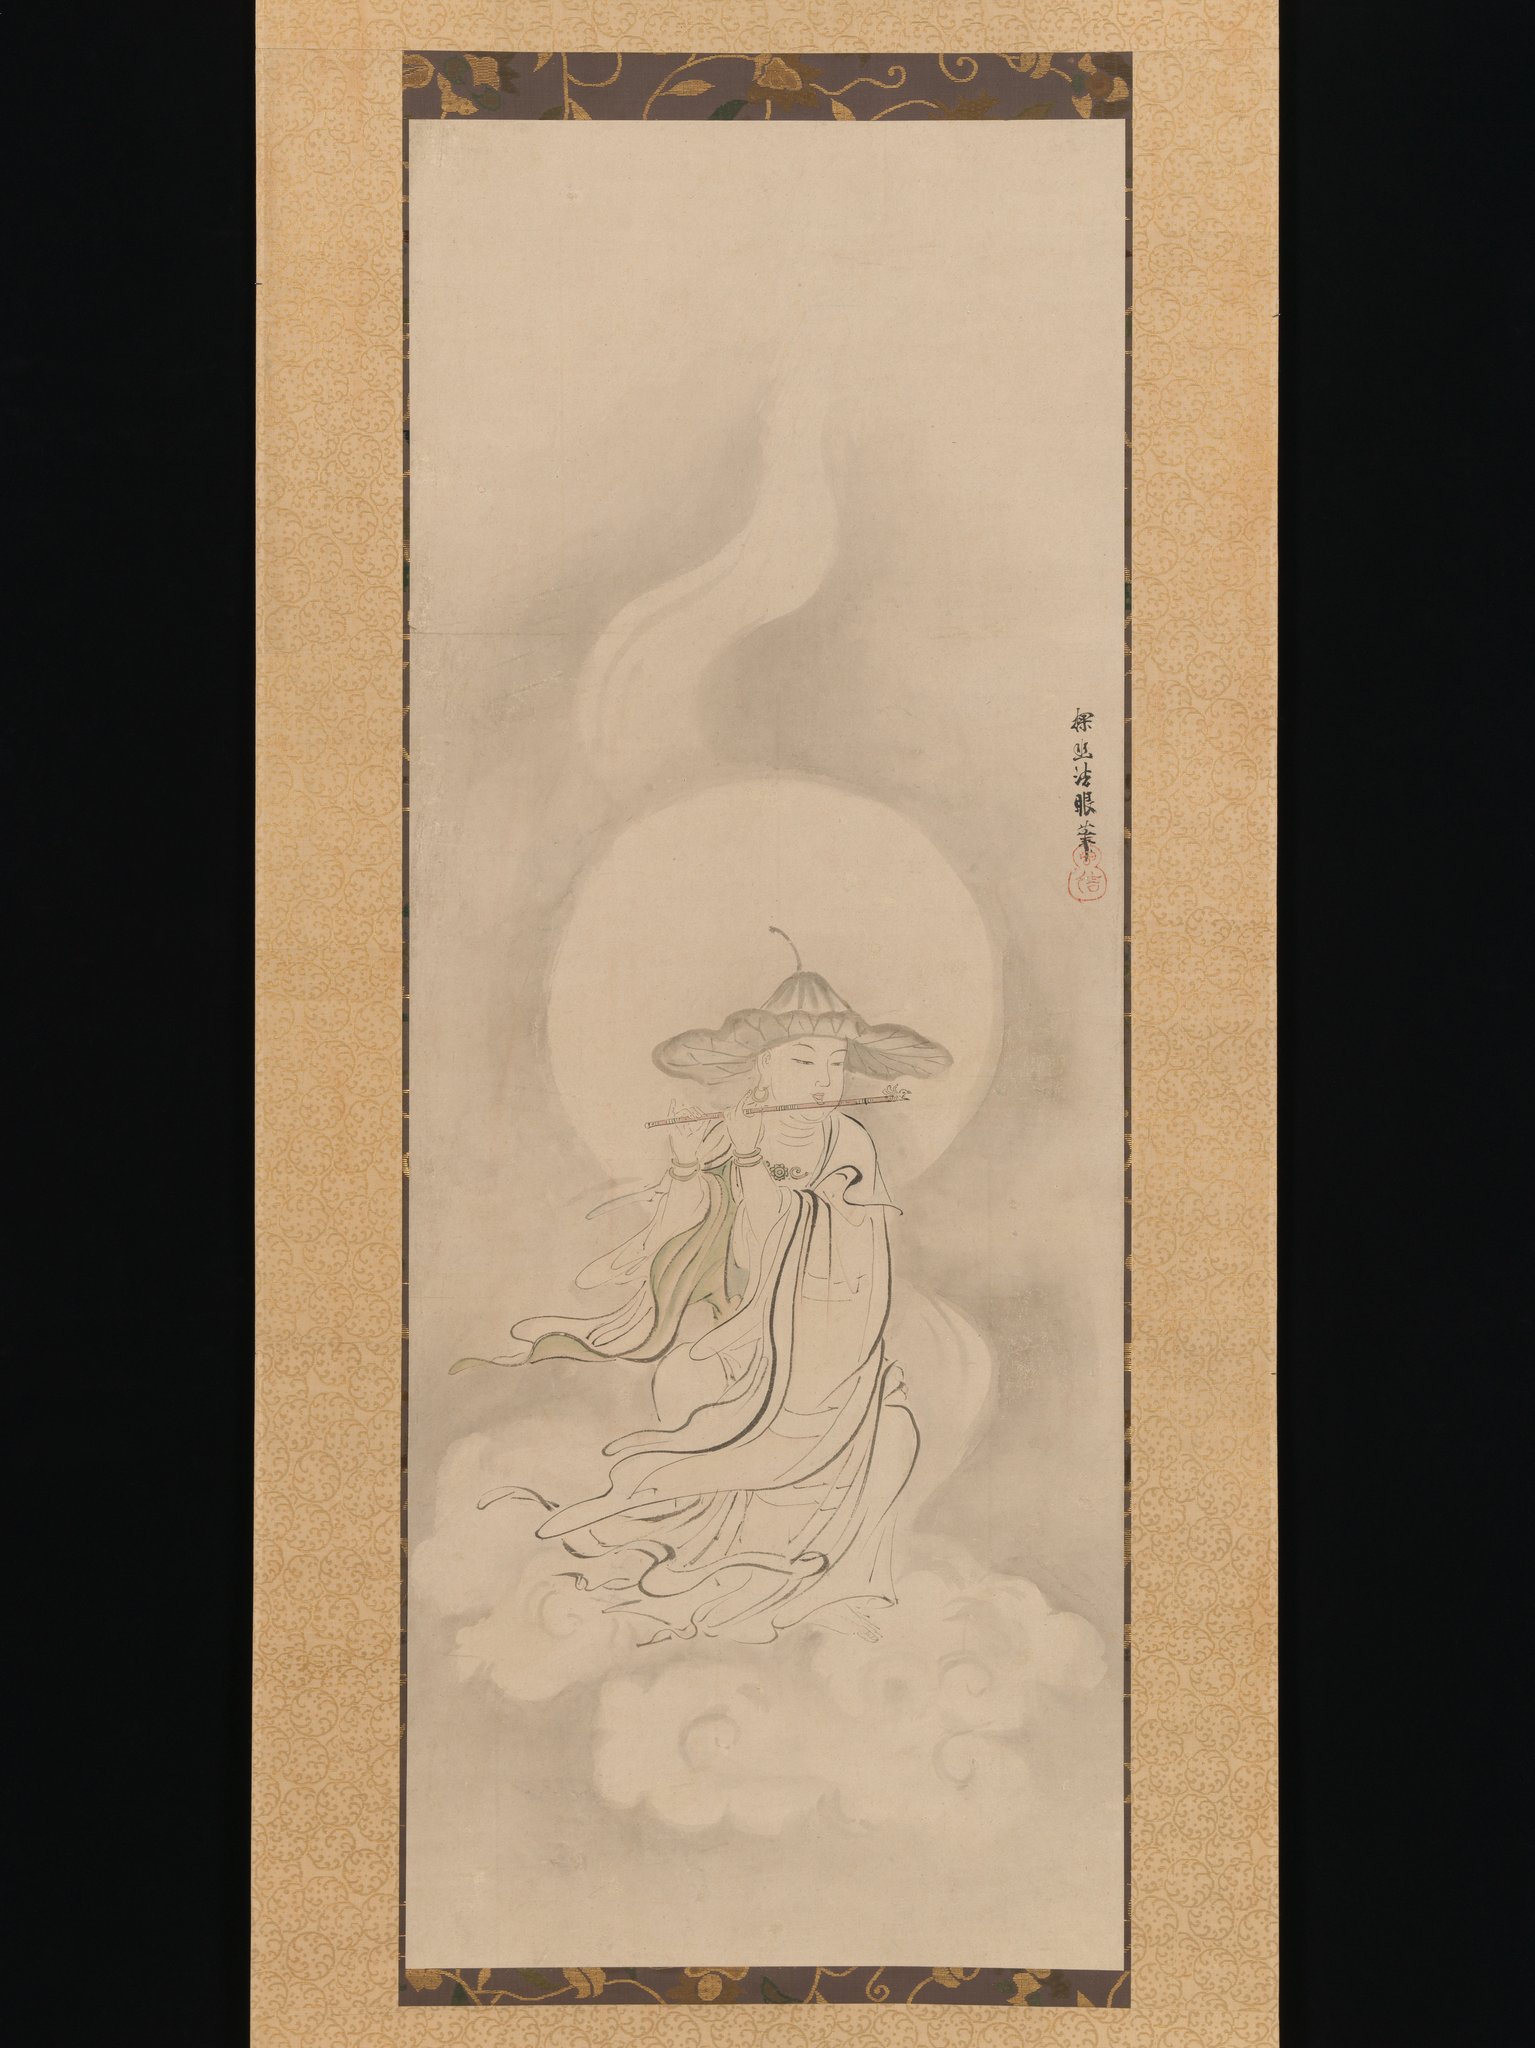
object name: hanging scroll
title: Jizō Bosatsu Playing a Flute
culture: japanese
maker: kano tan'yū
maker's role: artist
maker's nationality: japanese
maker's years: 1602-1674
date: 1634-1666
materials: ink, paper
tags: flutes,bodhisattvas